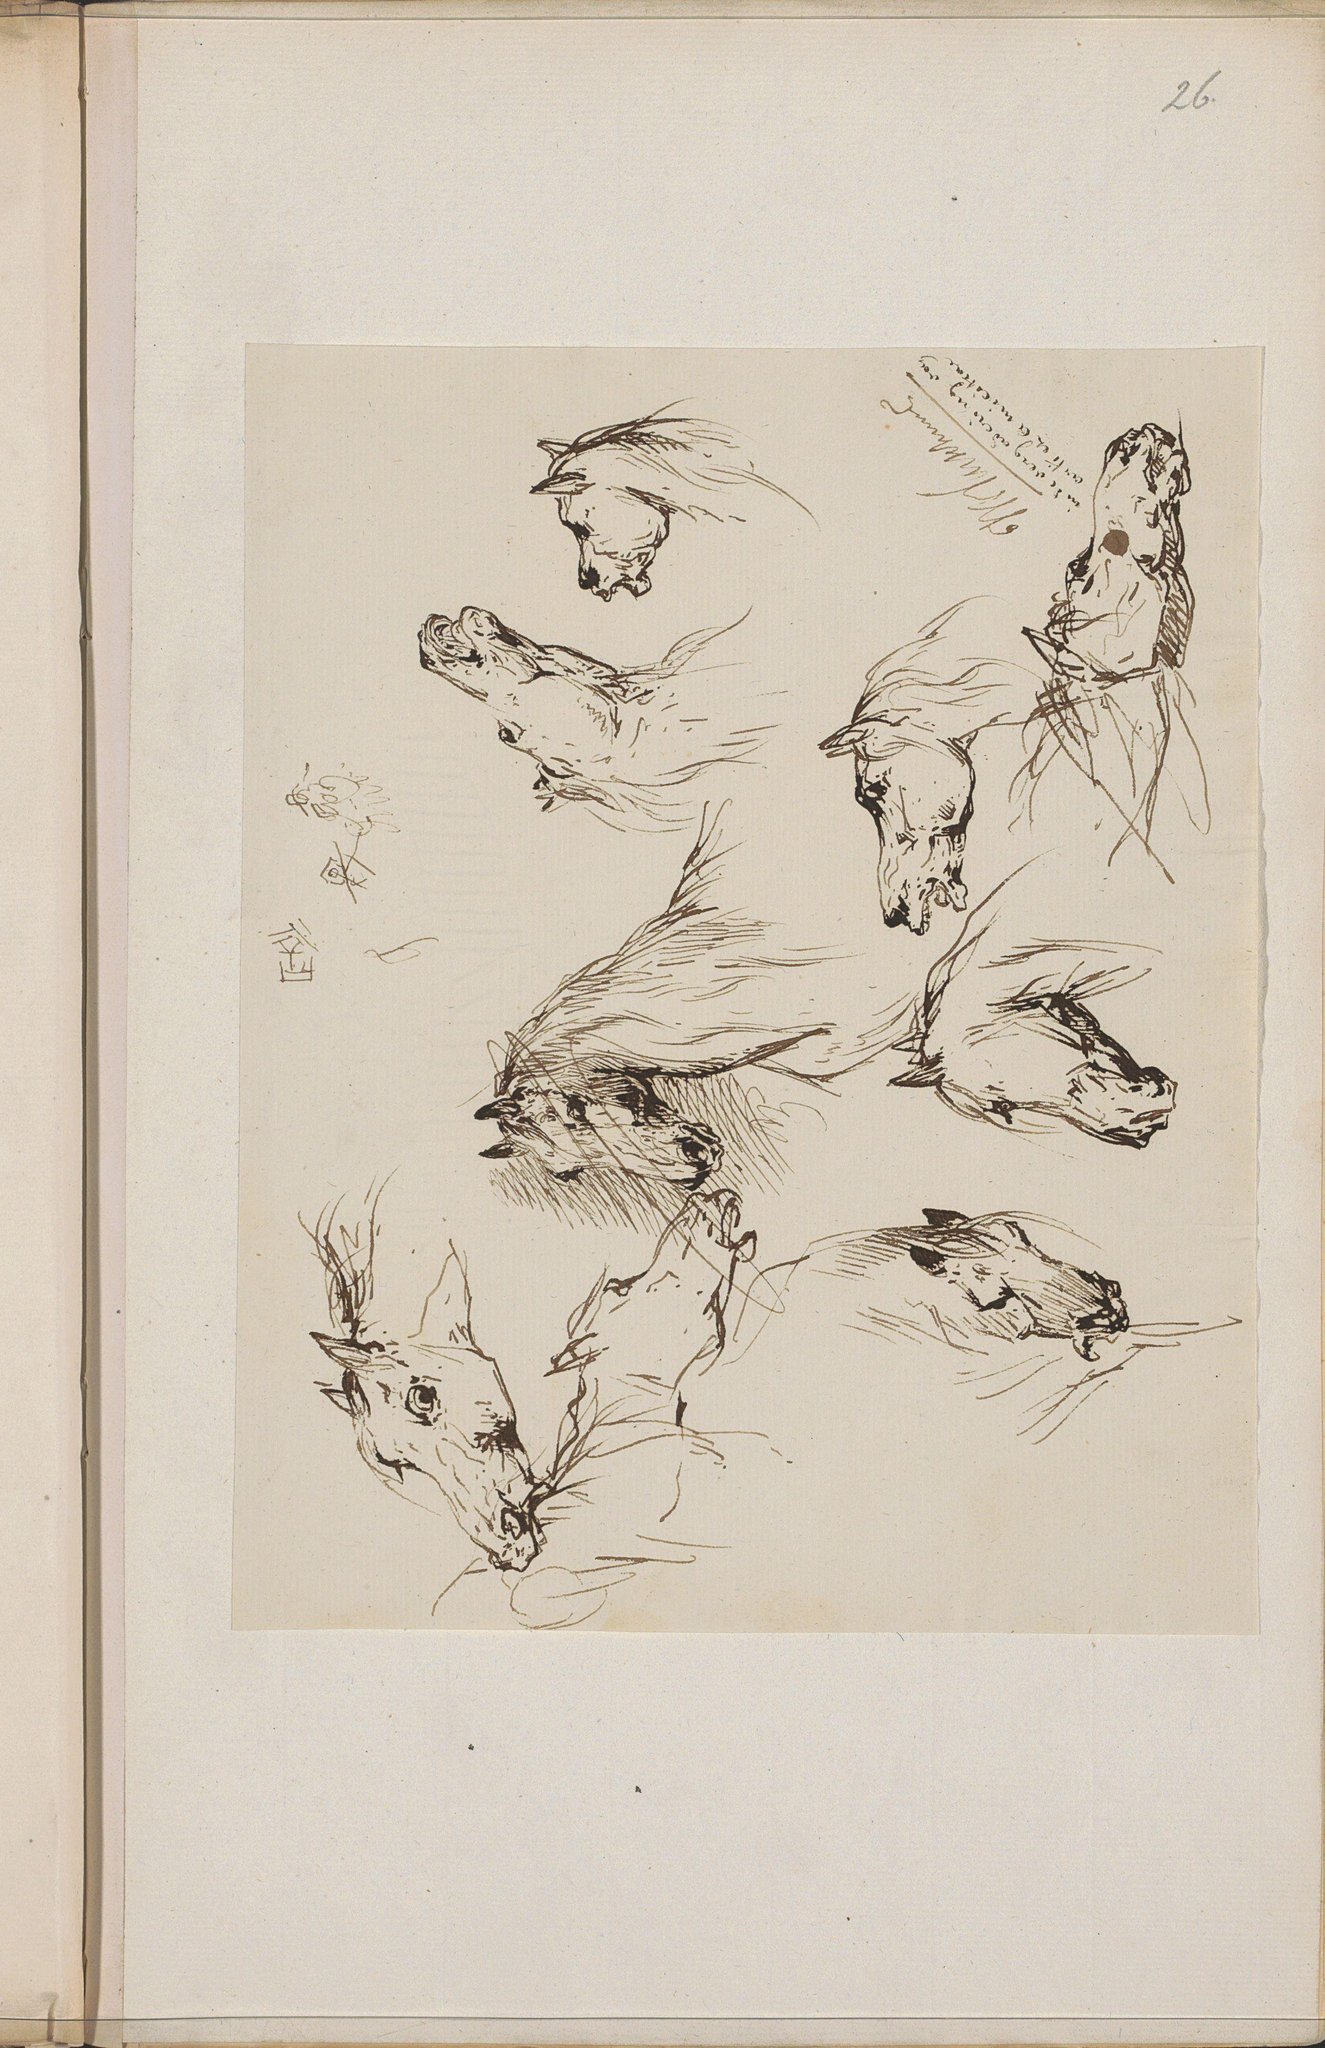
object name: album leaf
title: Paardenkoppen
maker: wouter verschuur (1812-1874)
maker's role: draughtsman, painter, print maker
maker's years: 1812-1874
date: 1843-1864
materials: ink, paper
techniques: pen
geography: amsterdam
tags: horse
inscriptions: annotation: ‘in de vergadering van/ arti et amicitiae.’, signature: ‘W Verschuur’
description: Blad 26 recto uit een verzamelalbum met 32 bladen.